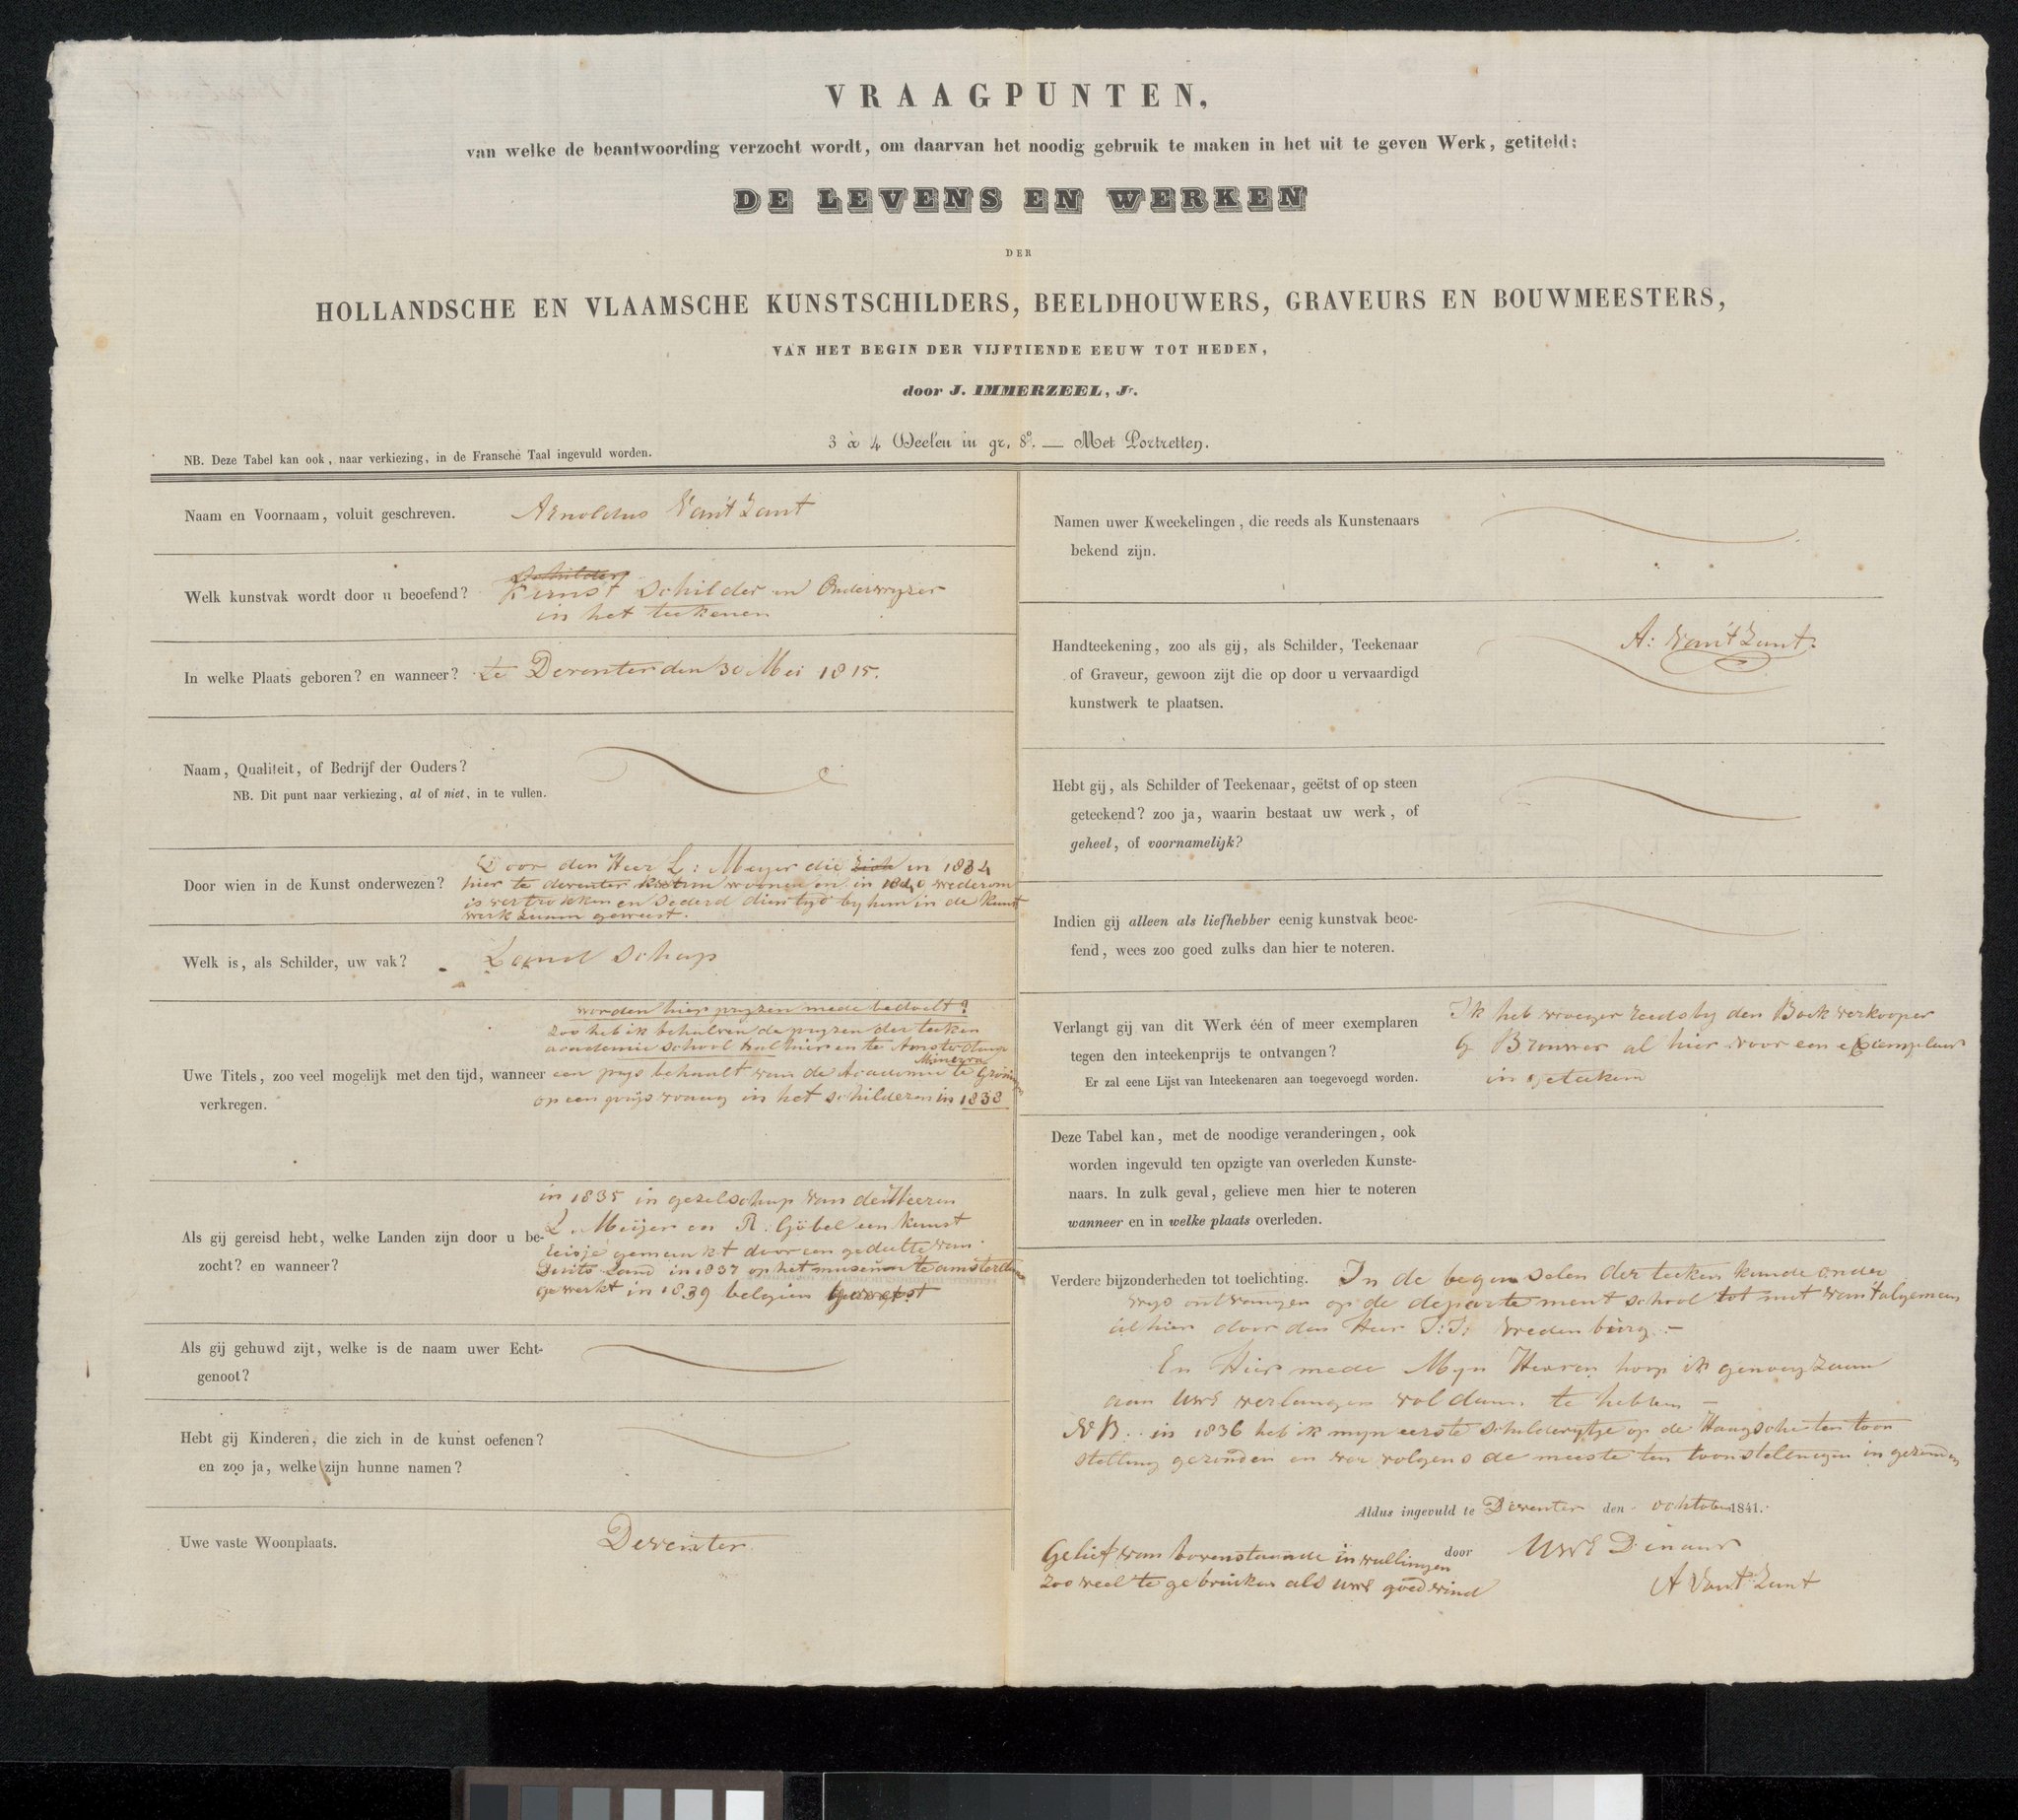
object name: questionnaire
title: Enquêteformulier ingevuld door Arnoldus Antonius Christianus van 't Zant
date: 1810-1841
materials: ink, paper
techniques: pen, printing, writing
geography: deventer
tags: deventer, print maker, arnoldus antonius christianus van 't zant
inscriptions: watermark, inscription: ‘Vraagpunten,/ van welke de beantwoording verzocht wordt, om daarvan het noodig gebruik te maken in het uit te geven Werk, getiteld: De levens en werken/ der Hollandsche en Vlaamsche kunstschilders, beeldhouwers,/ graveurs en bouwmeesters, van het begin der vijftiende eeuw tot heden/ door J. Immerzeel, Jr.’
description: Opgenomen in: Immerzeel, J. Jr., De levens en werken der Hollandsche en Vlaamsche kunstschilders, beeldhouwers, graveurs en bouwmeesters, van het begin der vijftiende eeuw tot heden, Amsterdam: J.C. van Kesteren, 1842-1843.